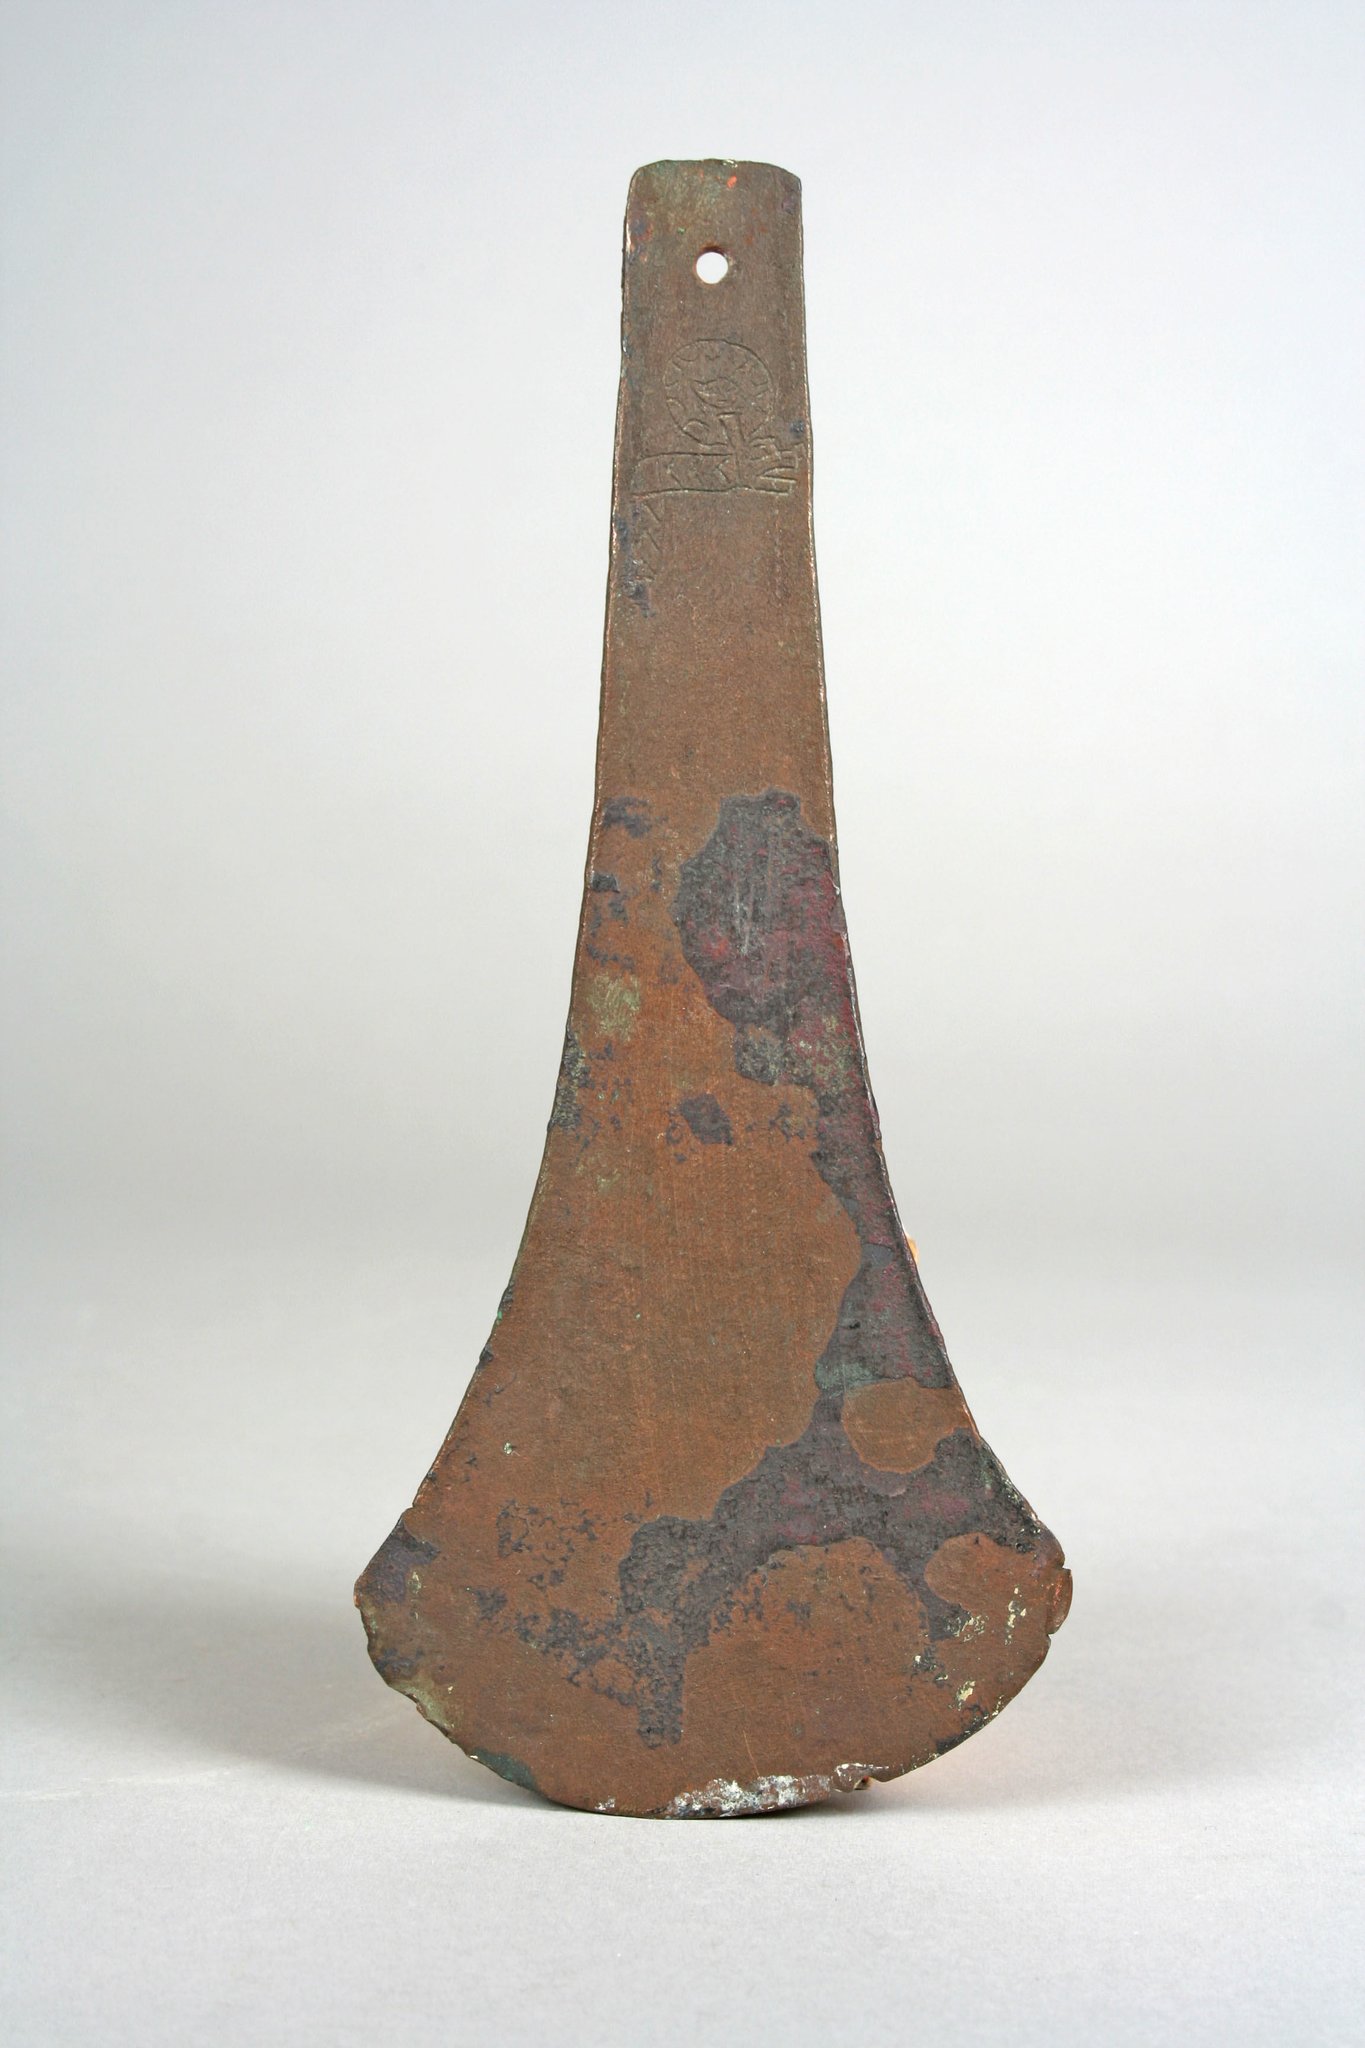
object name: knife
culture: moche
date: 1-500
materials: copper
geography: peru